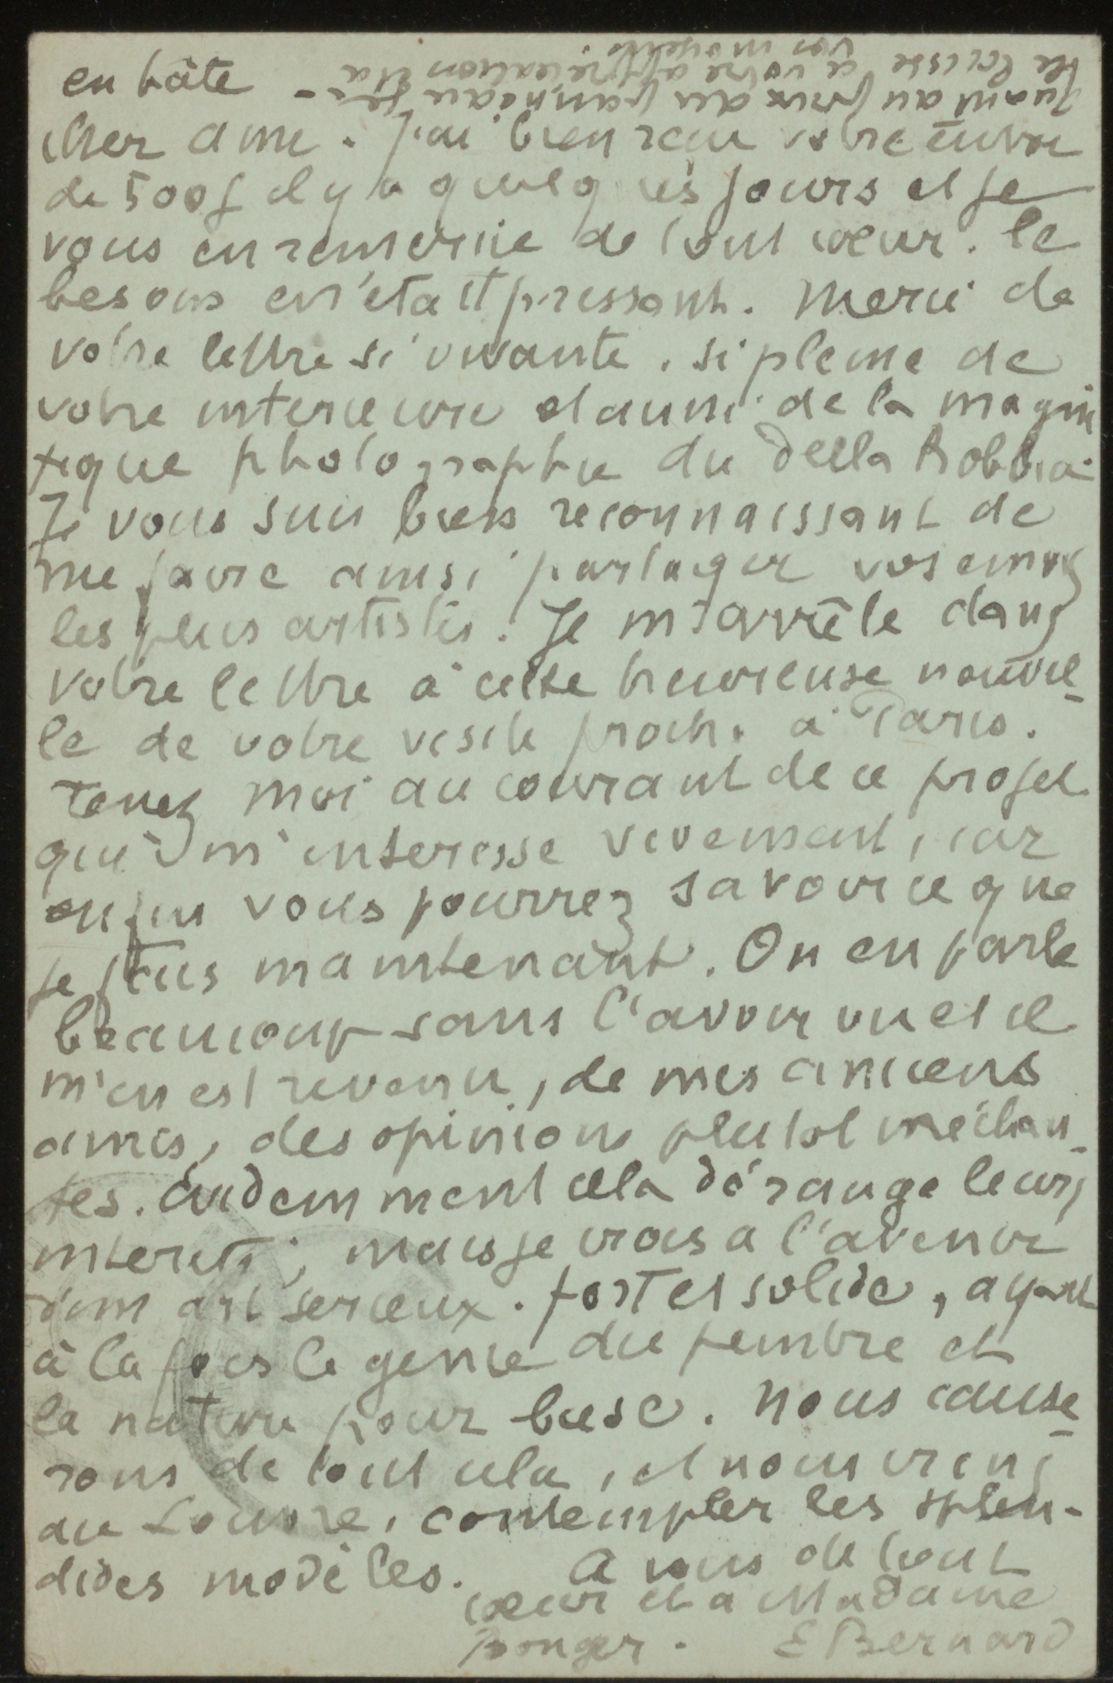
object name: postcard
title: Briefkaart aan Andries Bonger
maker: émile bernard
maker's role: print maker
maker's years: 1868-1941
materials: cardboard, ink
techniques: pen, writing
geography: paris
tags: luca della robbia, amsterdam, andries bonger, photography, cinematography, painting (including book-illumination, miniature-painting), money, paris